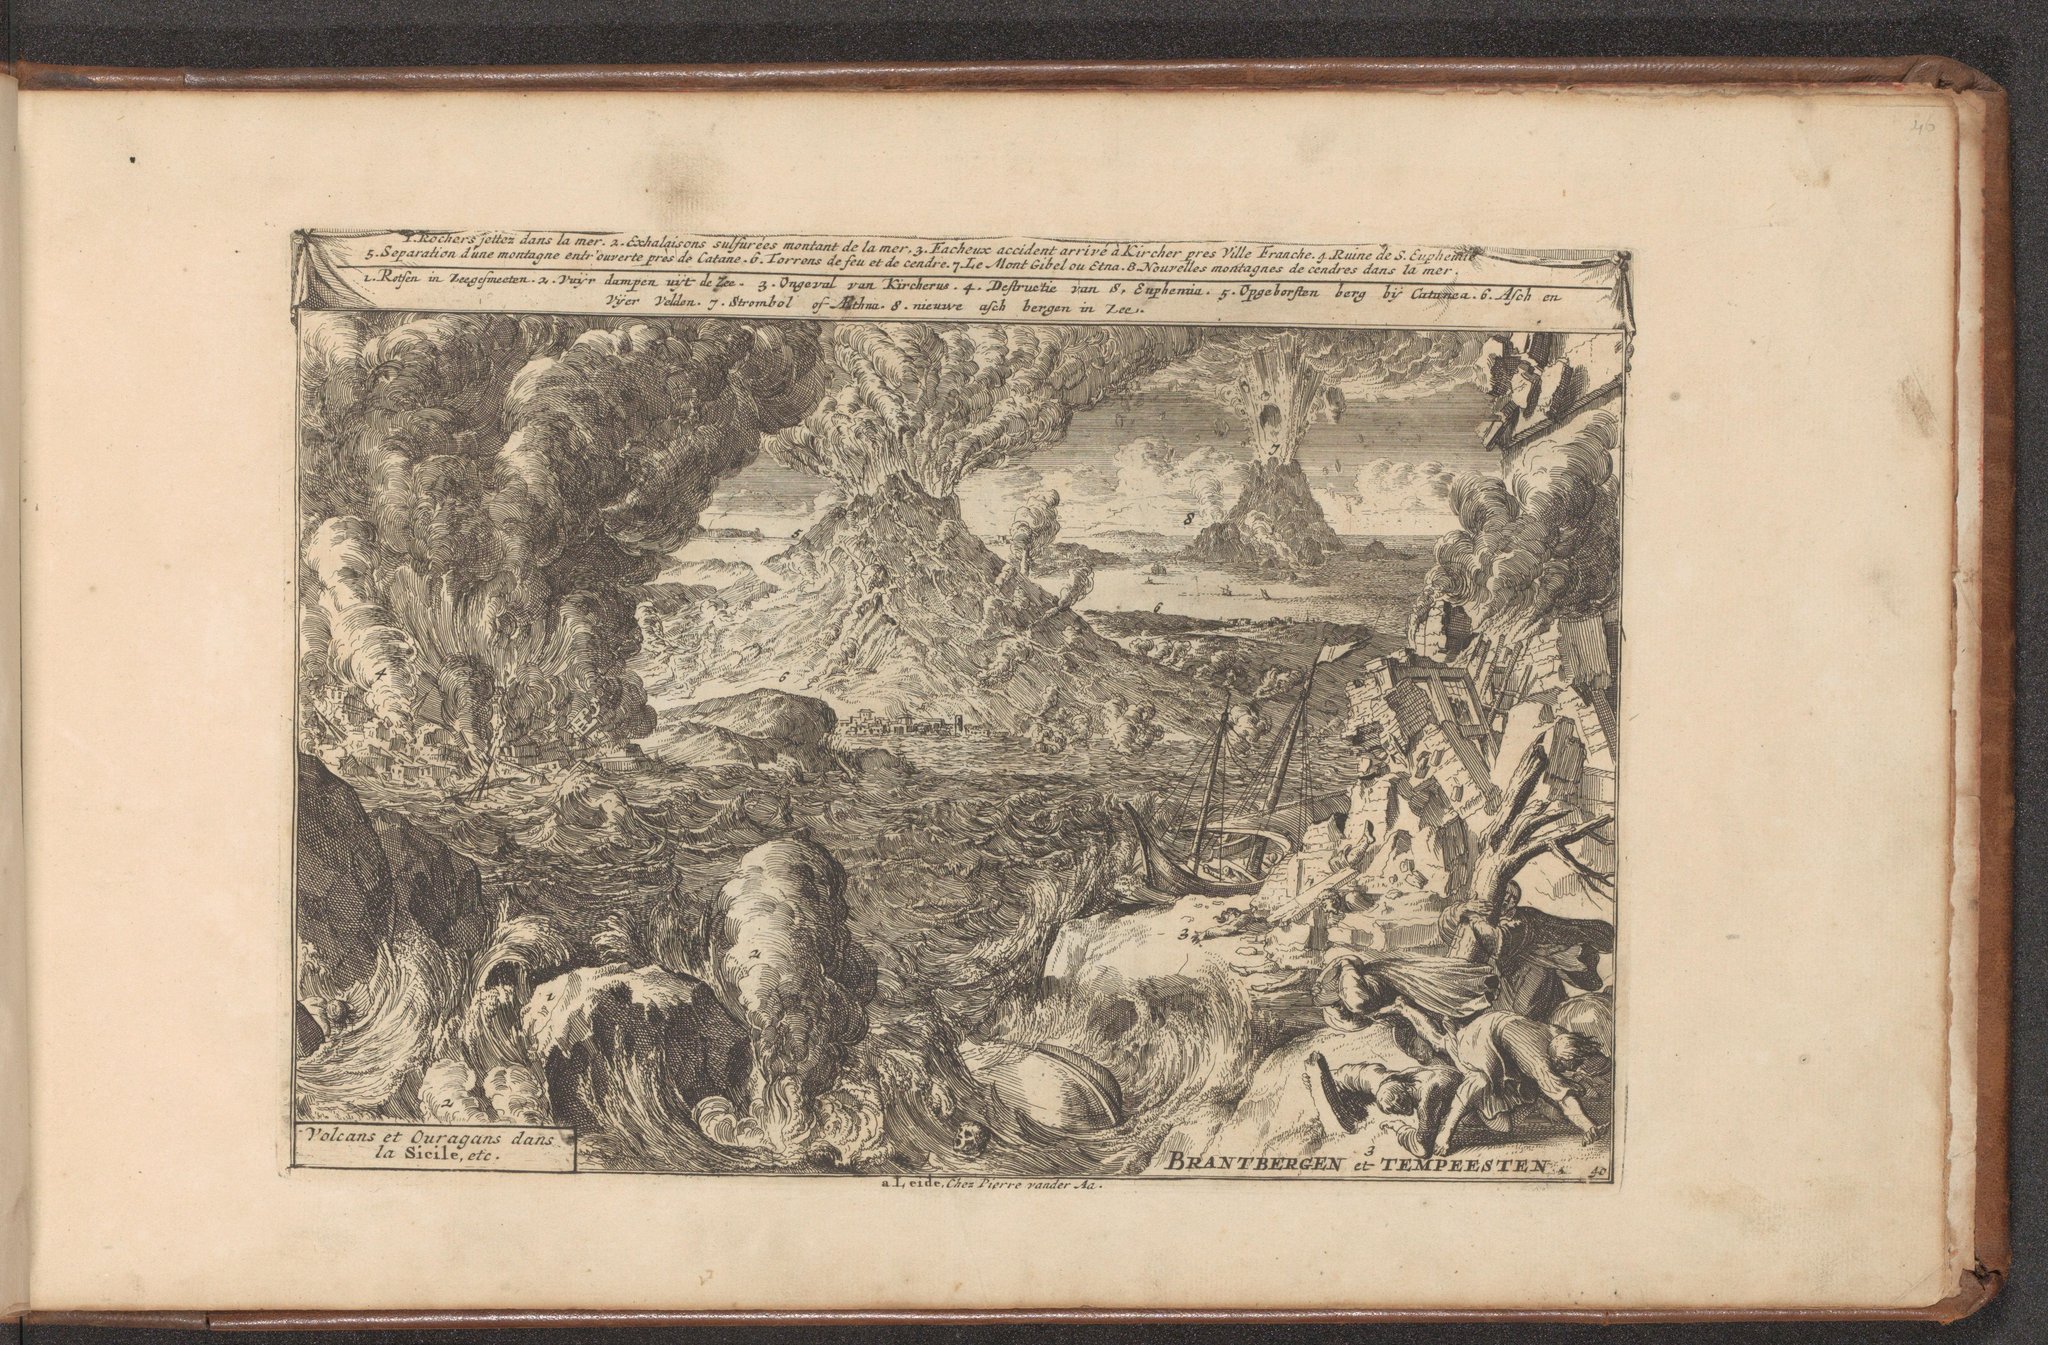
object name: album leaf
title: Brantbergen et Tempeesten / Volcans et Ouragans dans la Sicile, etc.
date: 1682-1733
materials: paper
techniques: etching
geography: leiden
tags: storm, volcano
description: Vulkanen en stormen. Op de voorgrond rechts worden de mensen door de wind omver geblazen. Een man heeft zijn handen om een boom geslagen. In het water ligt een man naast een omgeslagen boot. Met een legenda in het Nederlands en het Frans. De prent maakt deel uit van een album.